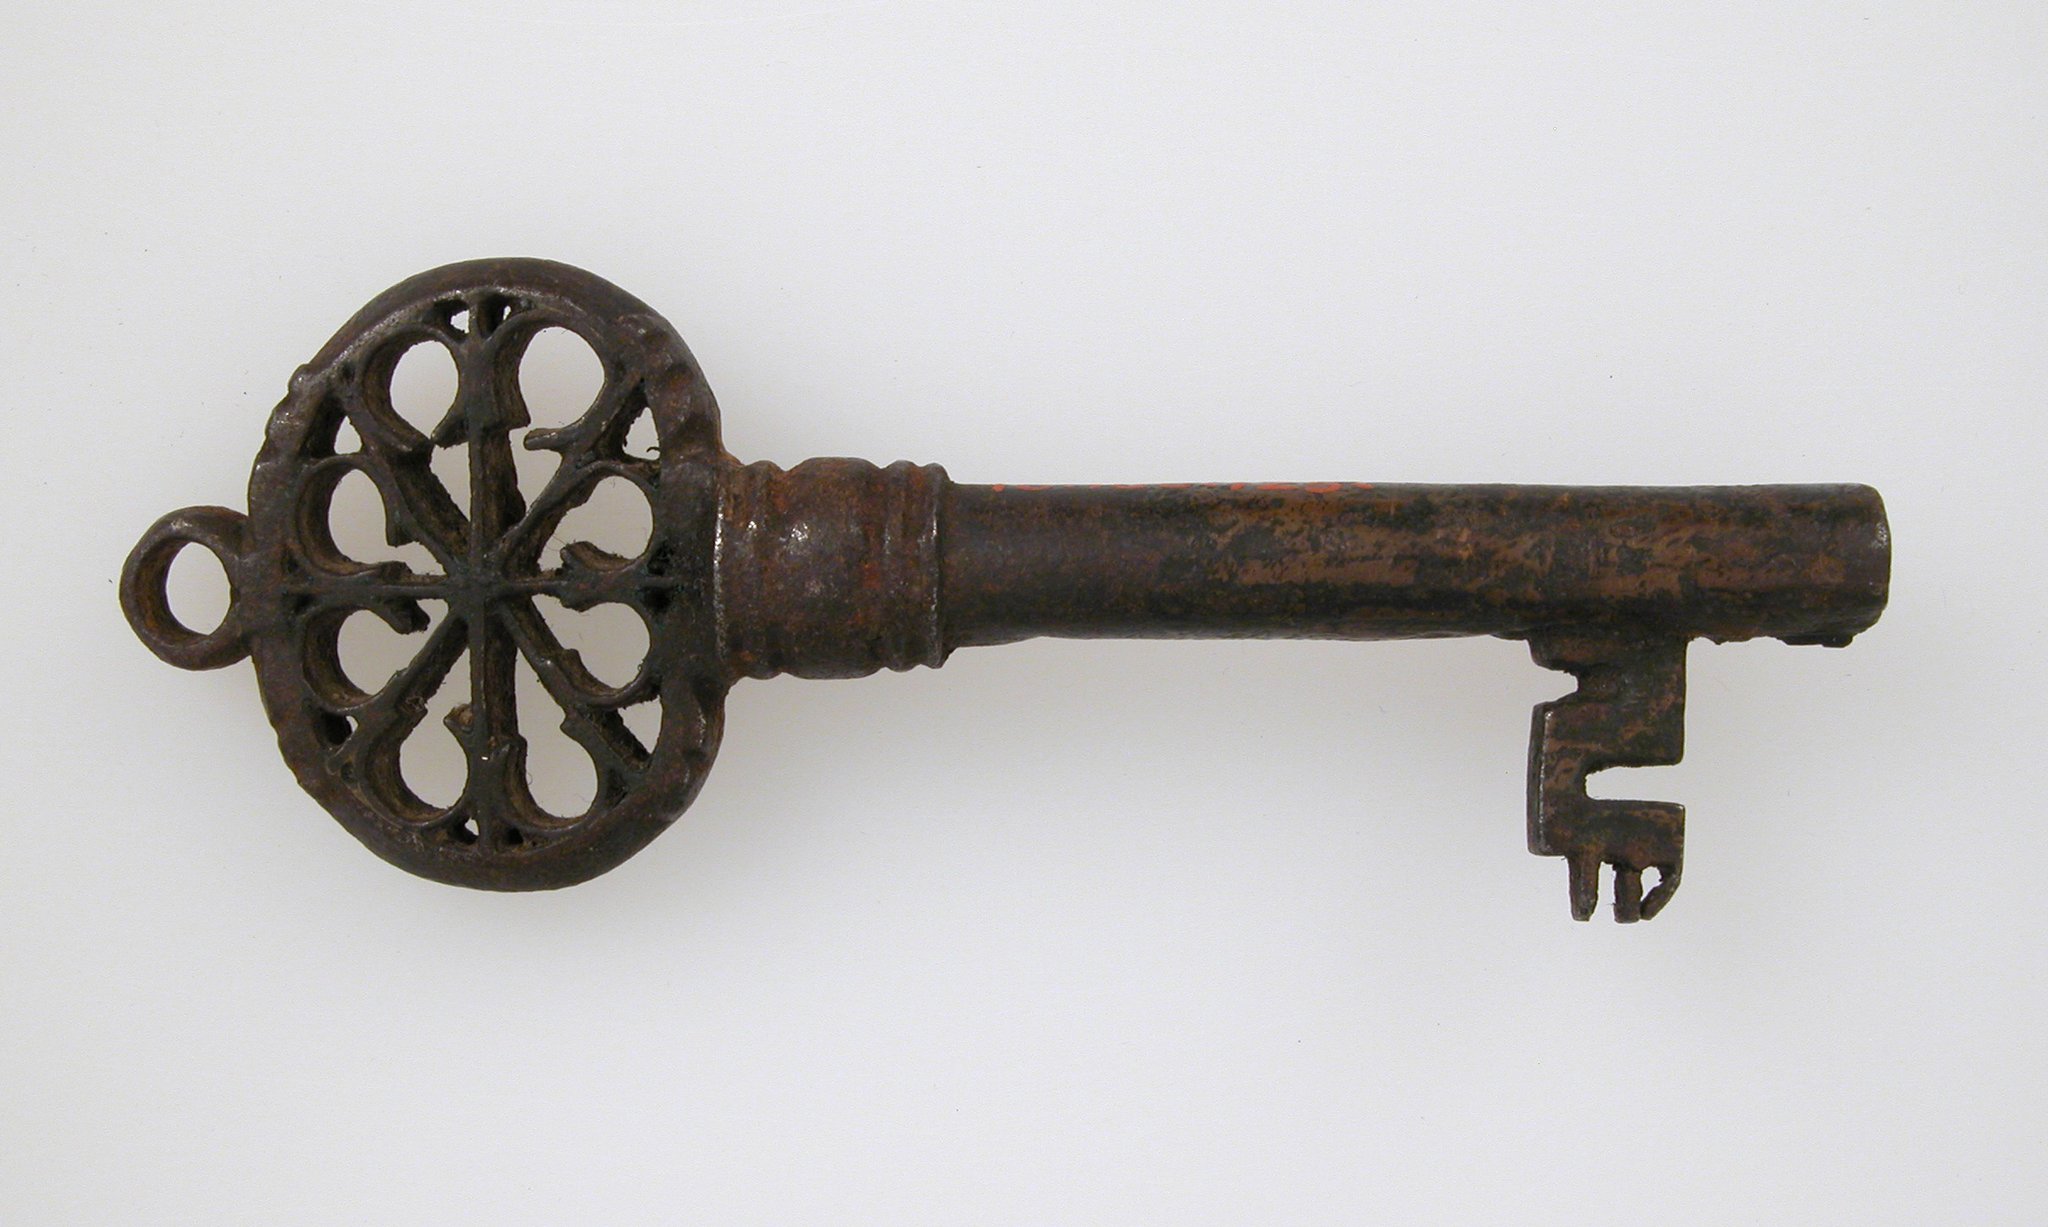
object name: key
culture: german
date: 1401-1500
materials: iron